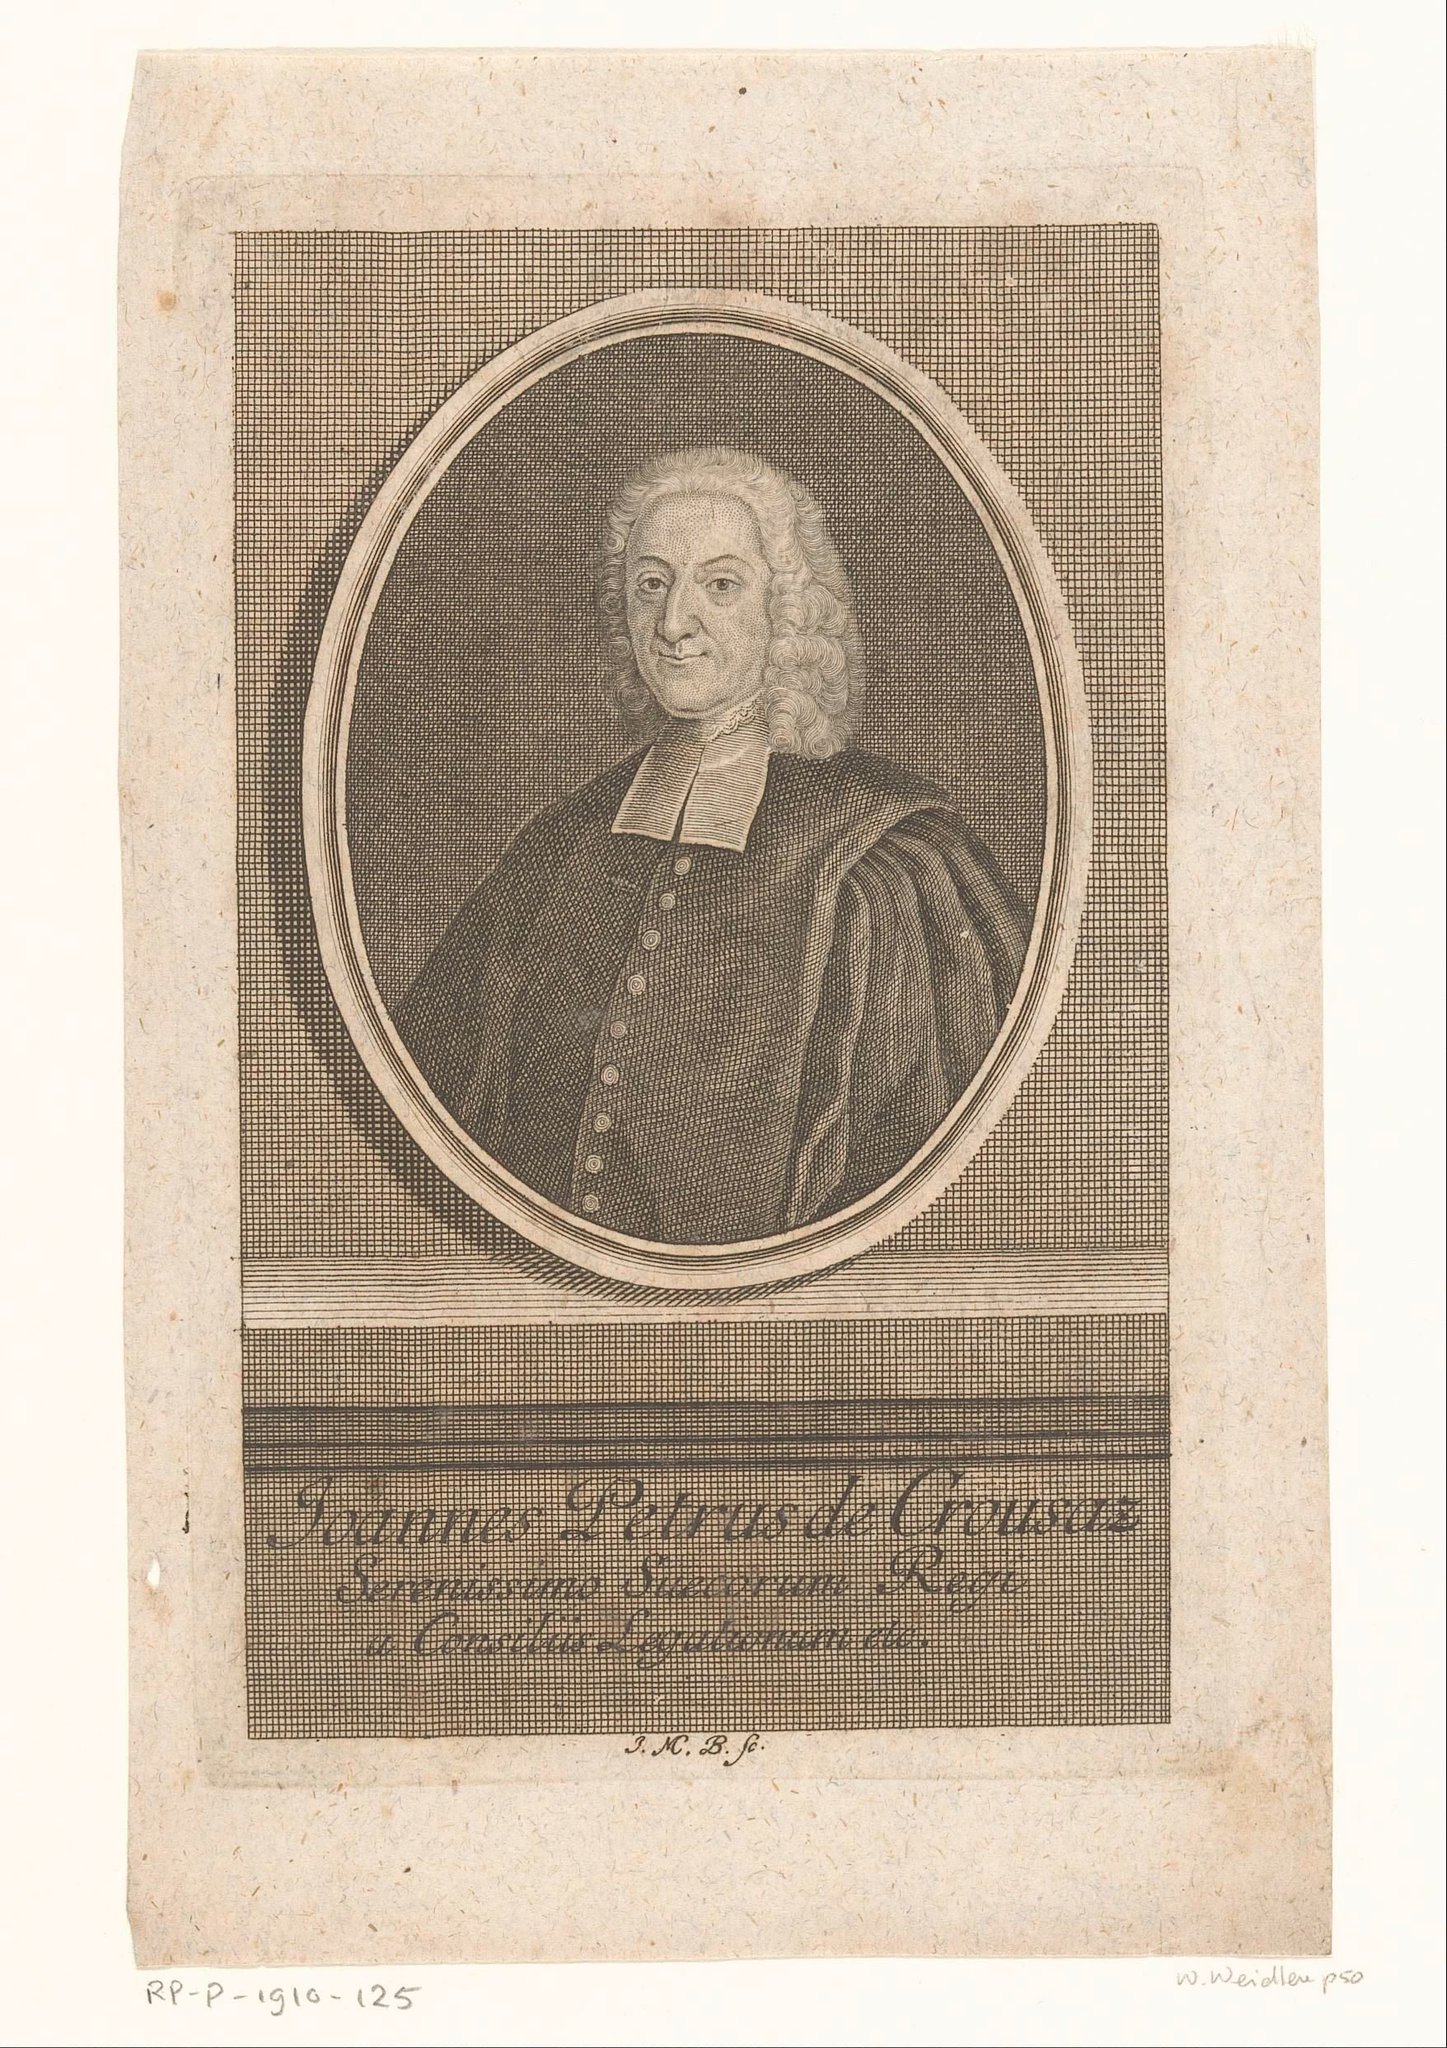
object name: print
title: Portret van Jean-Pierre de Crousaz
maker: johann martin bernigeroth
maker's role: print maker, publisher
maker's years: 1713-1767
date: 1742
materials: paper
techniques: engraving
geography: leipzig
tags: historical persons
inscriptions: collector's mark: Lugt 2228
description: Prent ook gebruikt in: Zuverlässige Nachrichten von dem gegenwärtigen Zustande, Veränderung und Wachsthum der Wissenschaften. dl. 27. Leipzig: Johann Friedrich Gleditsch, 1742.